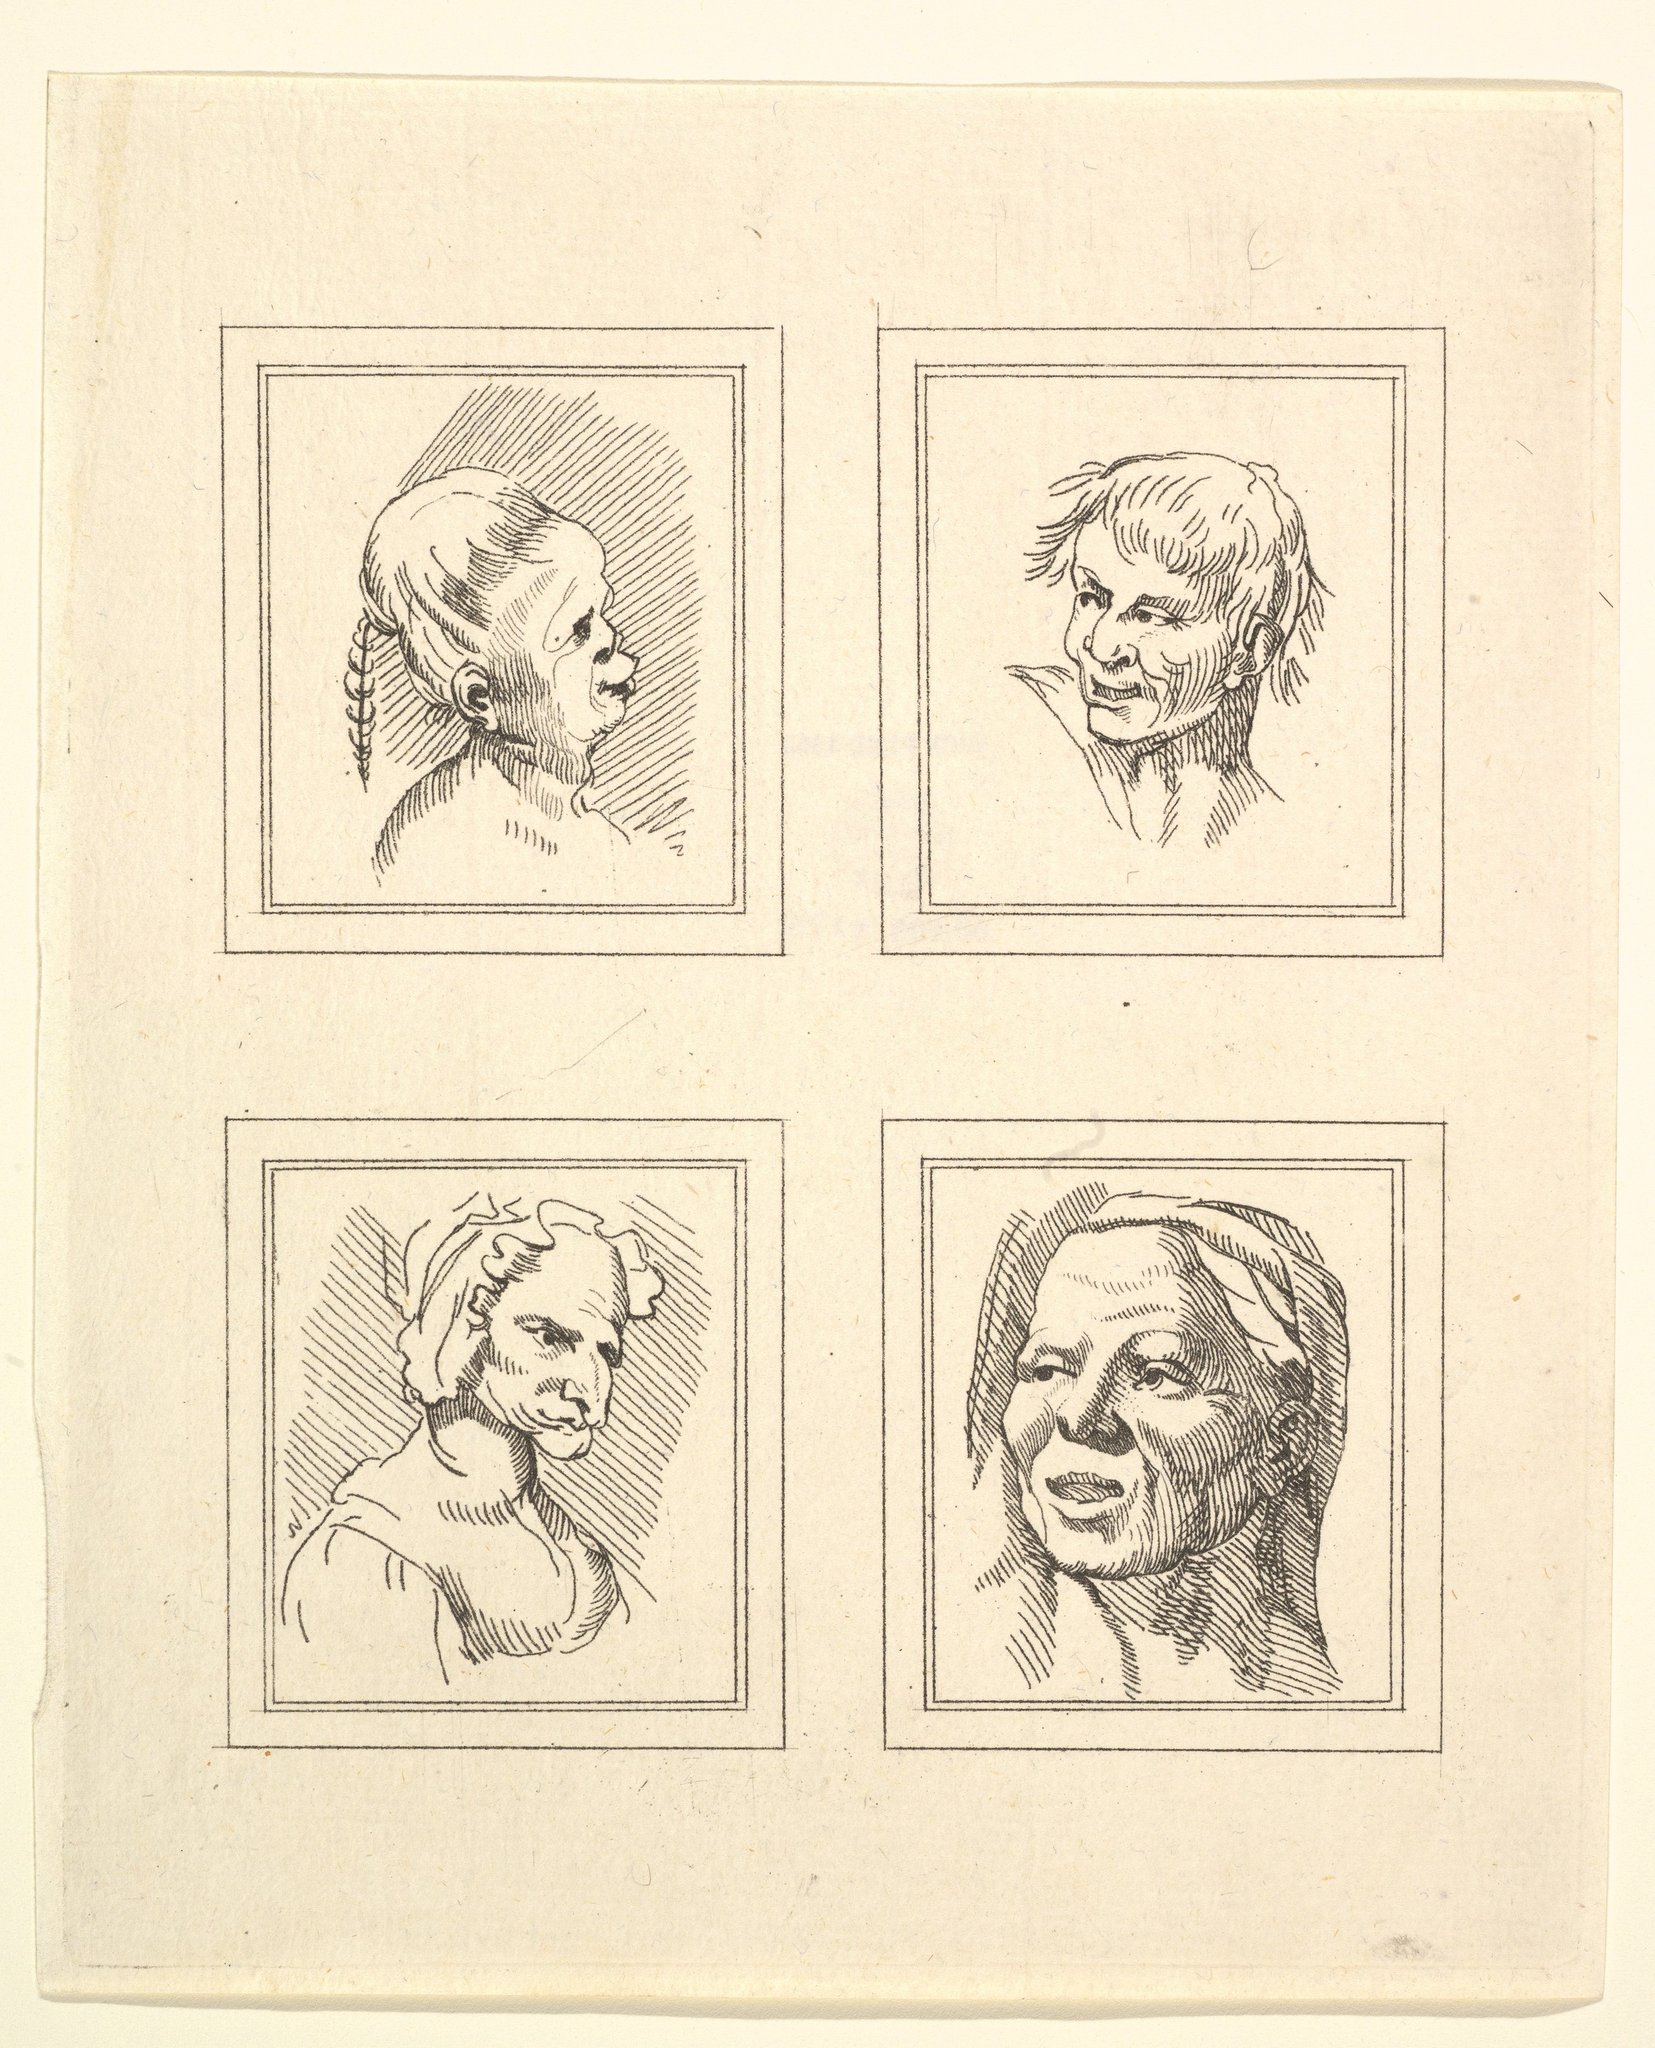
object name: print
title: Four Heads (from Characaturas by Leonardo da Vinci, from Drawings by Wincelslaus Hollar, out of the Portland Museum)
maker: wenceslaus hollar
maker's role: artist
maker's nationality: bohemian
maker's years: 1607-1677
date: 1786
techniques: etching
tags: heads,men